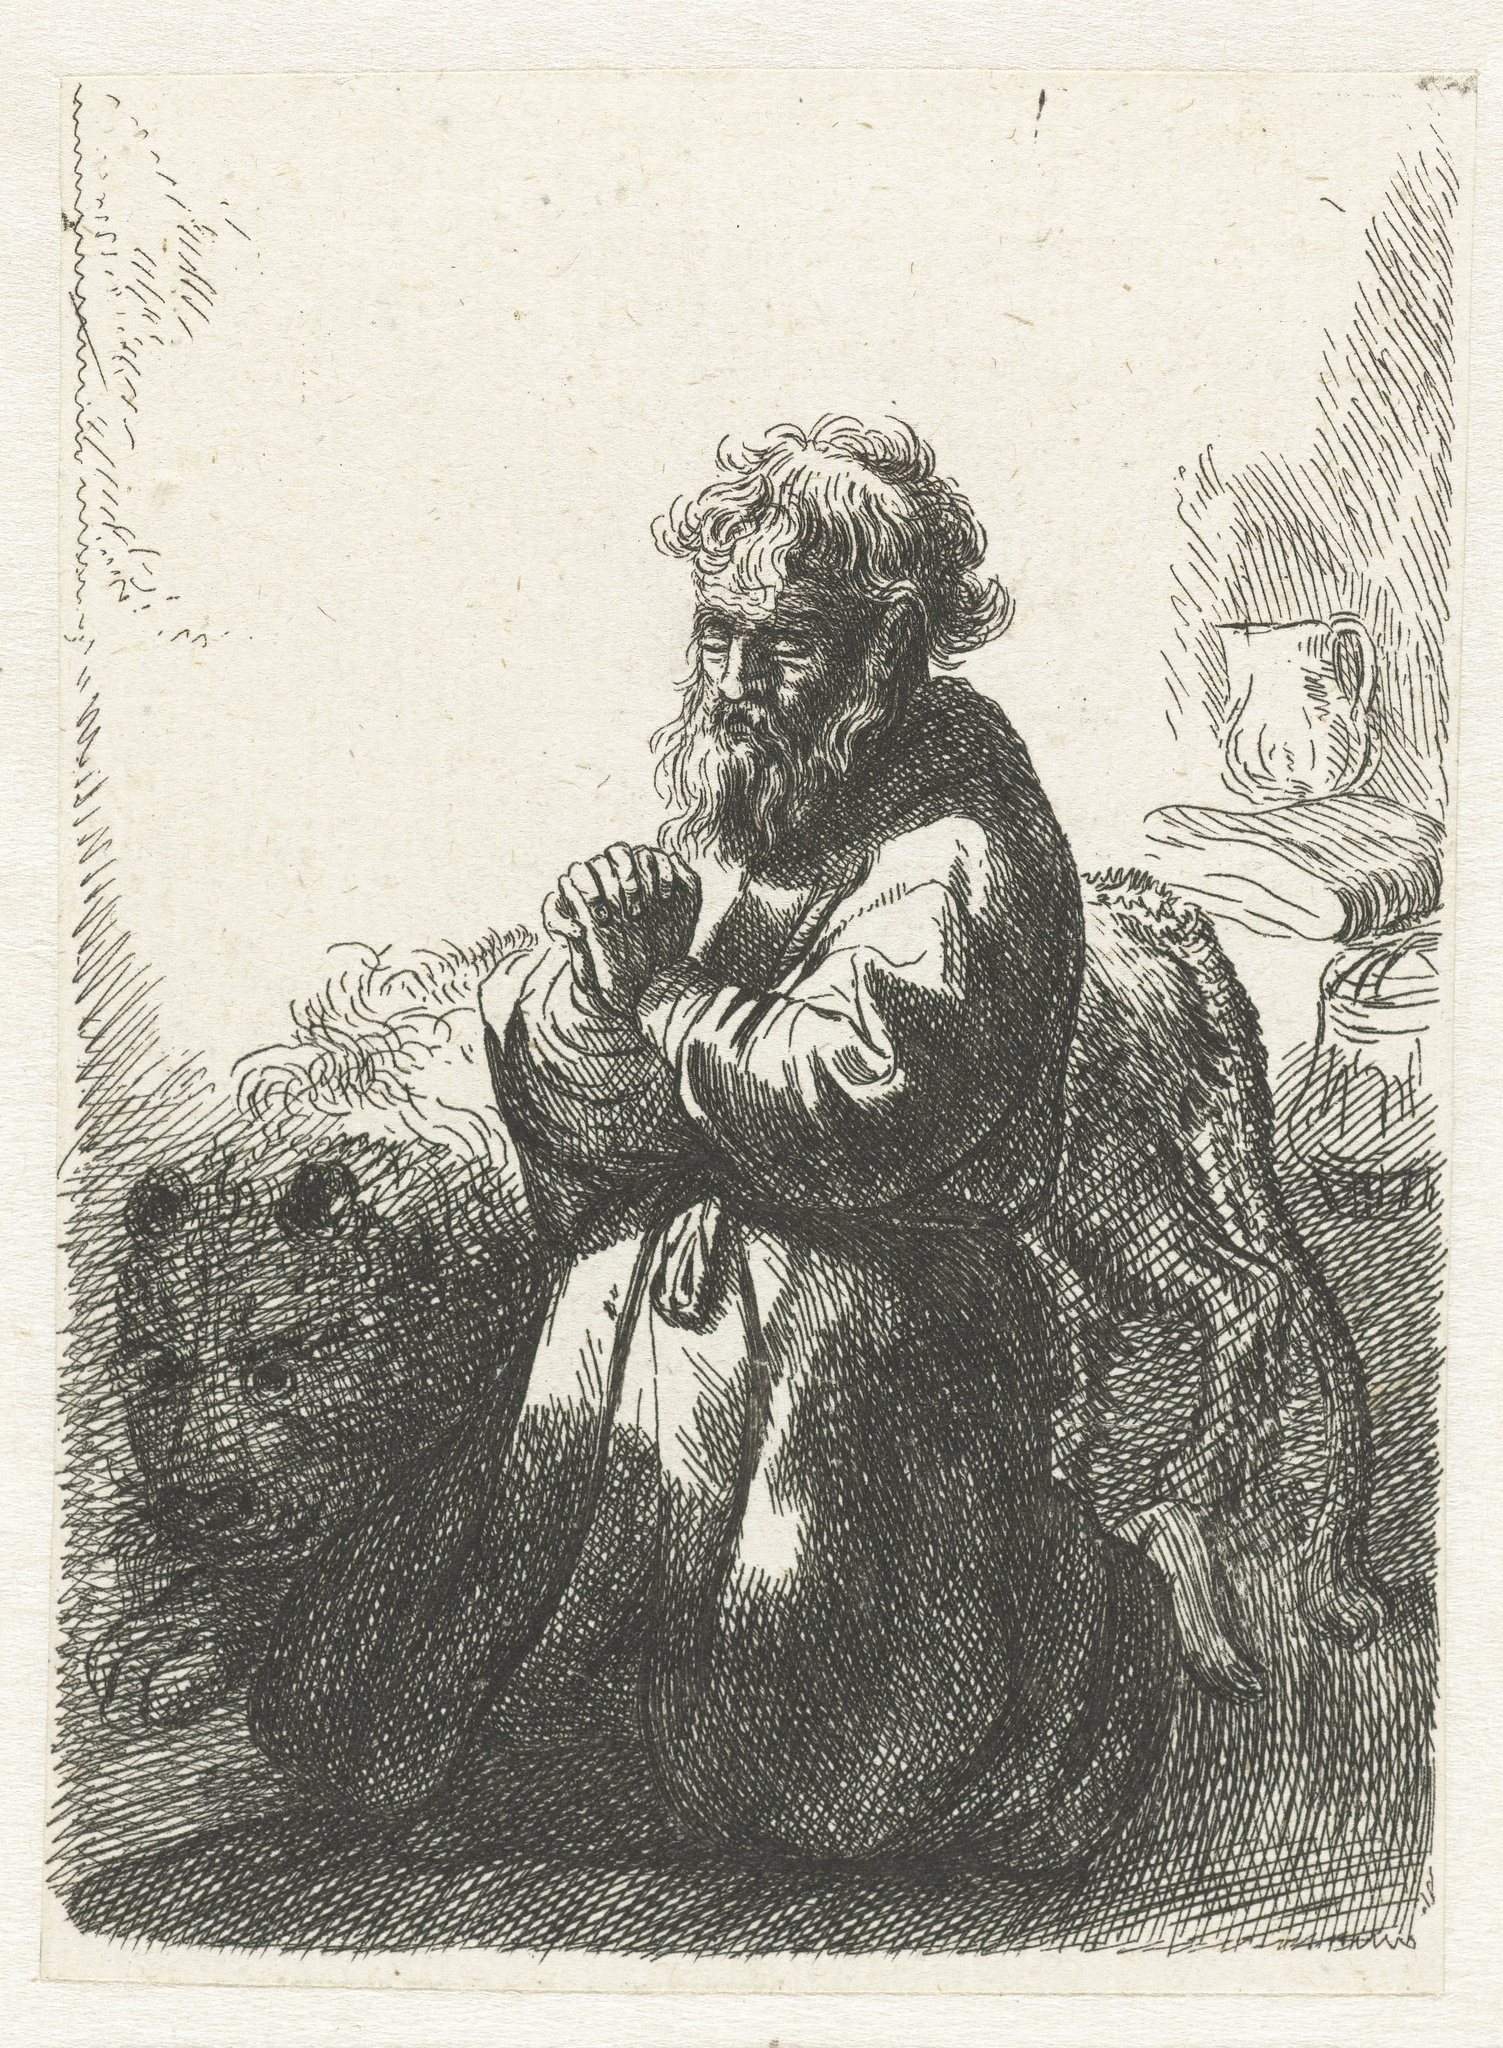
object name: print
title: St Jerome kneeling in prayer, looking down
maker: willem van der vliet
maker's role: painter, print maker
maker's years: 1584-1642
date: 1635-1642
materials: paper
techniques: etching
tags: the monk and hermit jerome (hieronymus); possible attributes: book, cardinal's hat, crucifix, hour-glass, lion, skull, stone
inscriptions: collector's mark: Lugt 2760, collector's mark: Lugt 2228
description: Spiegelbeeldige kopie naar de gelijknamige prent van Rembrandt.